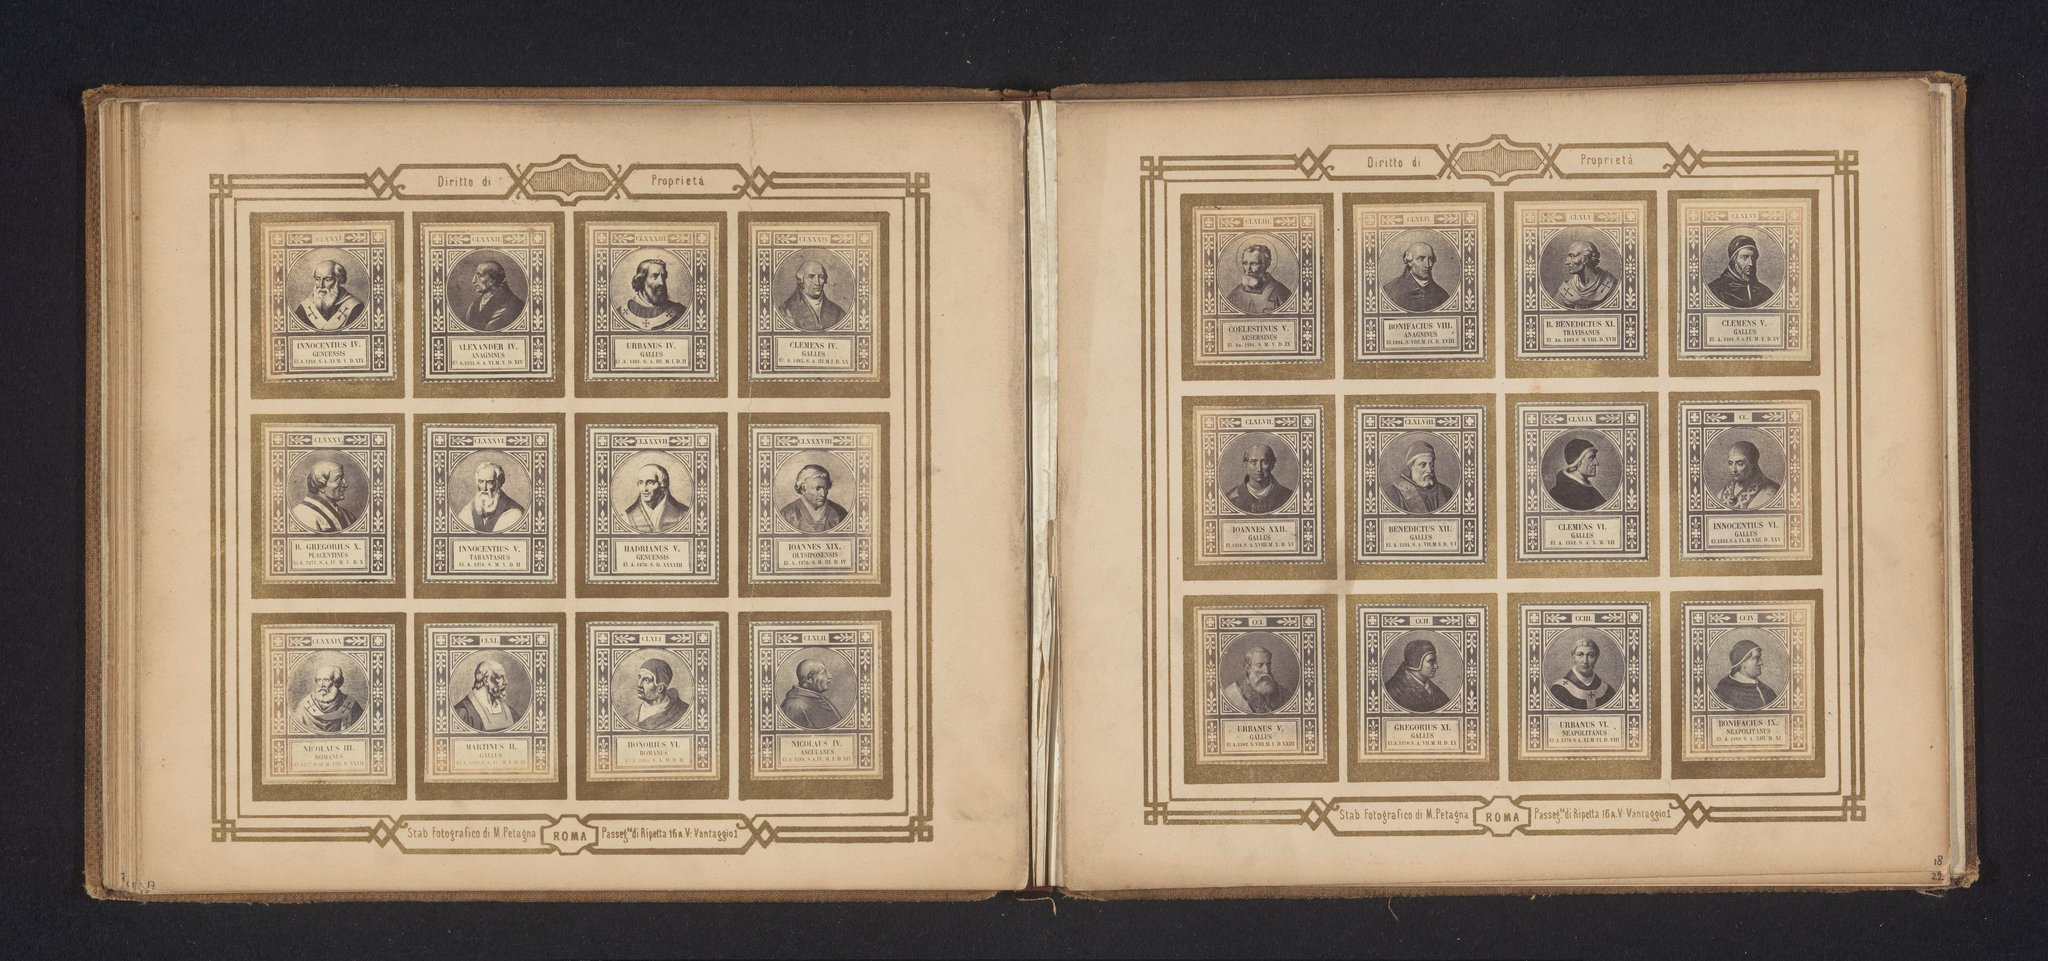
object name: reproduction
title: Fotoreproductie van twaalf portretten van pausen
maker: m. petagna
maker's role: fotograaf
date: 1854-1864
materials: photographic support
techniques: albumen print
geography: rome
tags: pope